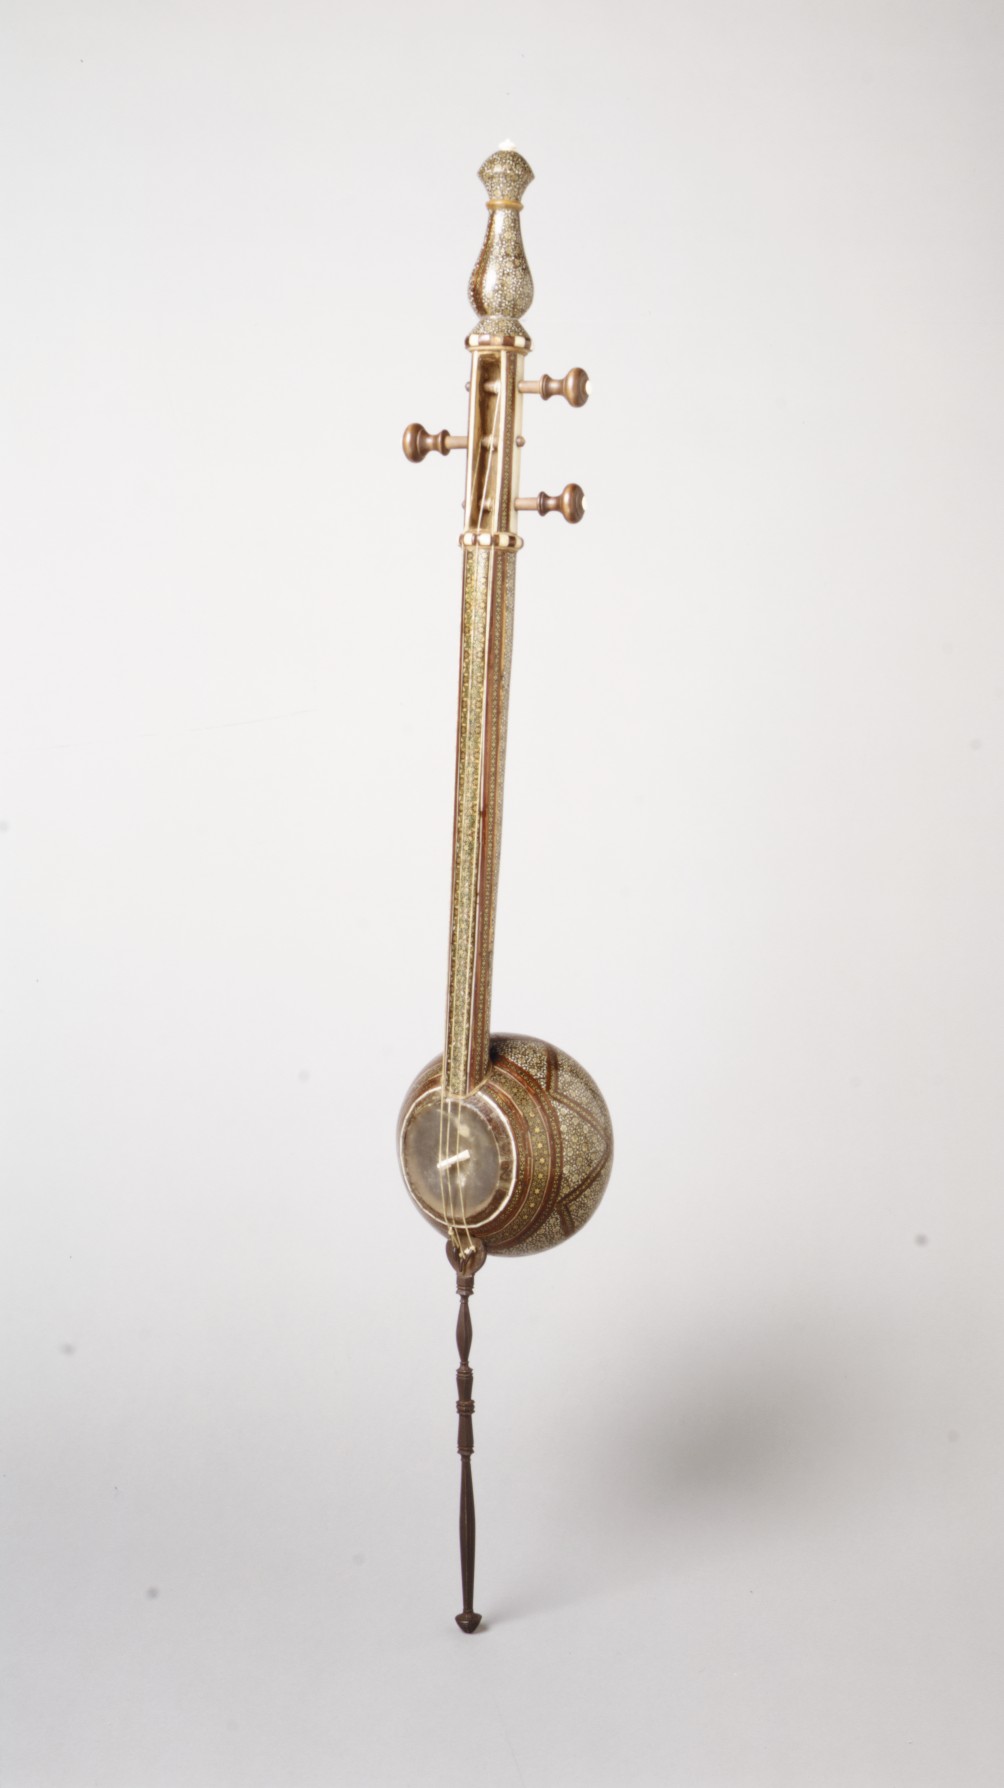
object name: kamanche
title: Kamānche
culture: iranian or persian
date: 1880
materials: bone, metal, wood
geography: iran